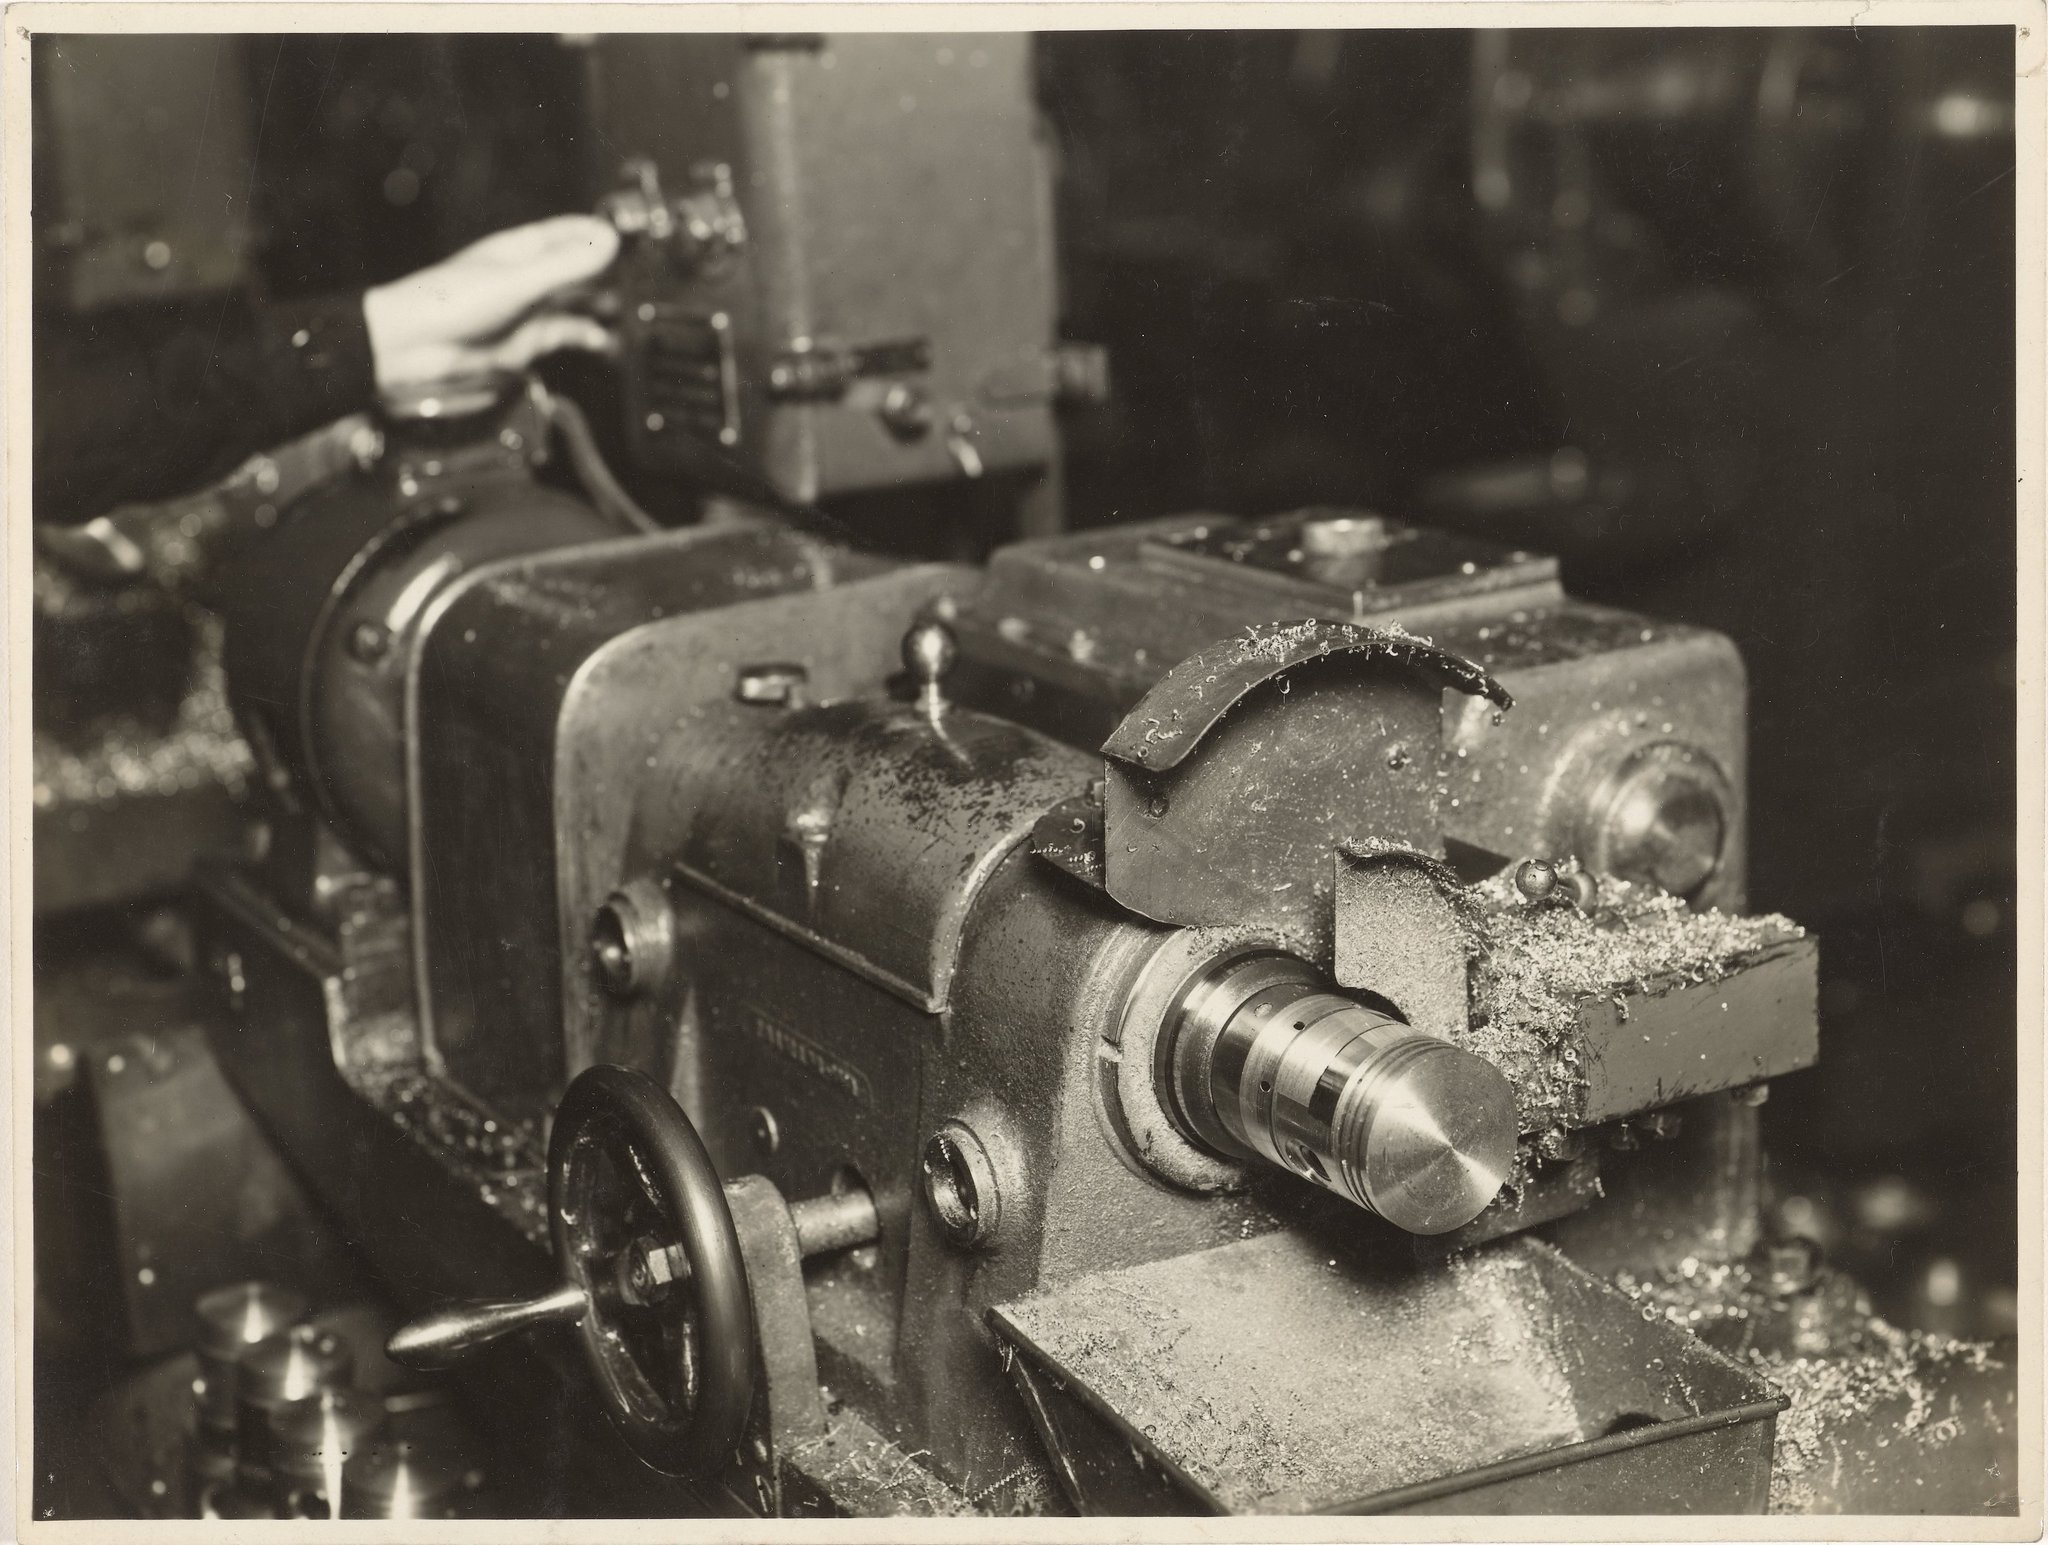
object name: photograph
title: Metaaldraaibank in de Ward End Works, de fabriek van de Wolseley Motor Company in Birmingham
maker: f.r. logan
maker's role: fotograaf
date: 1932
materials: paper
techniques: gelatin silver print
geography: birmingham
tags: automobile, birmingham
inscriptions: address: ‘33 GT: CHARLES ST. B'HAM.’